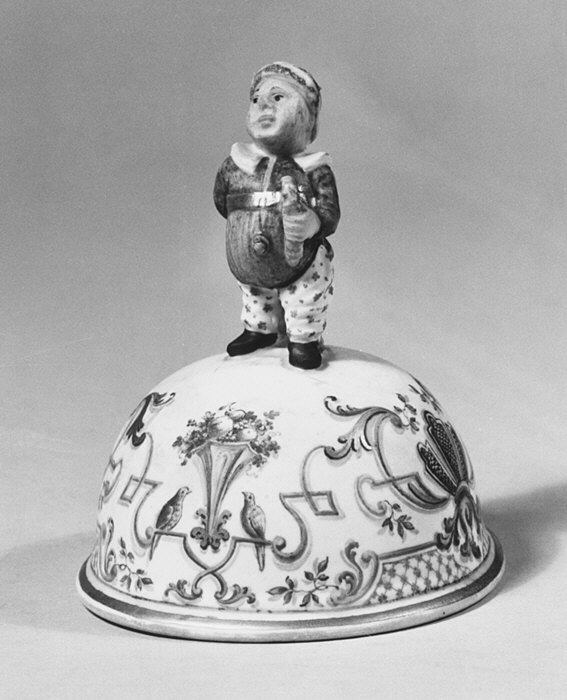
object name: bell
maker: vienna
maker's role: manufactory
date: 1701-1800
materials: hard paste porcelain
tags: musical instruments,birds,fruit,men,leaves